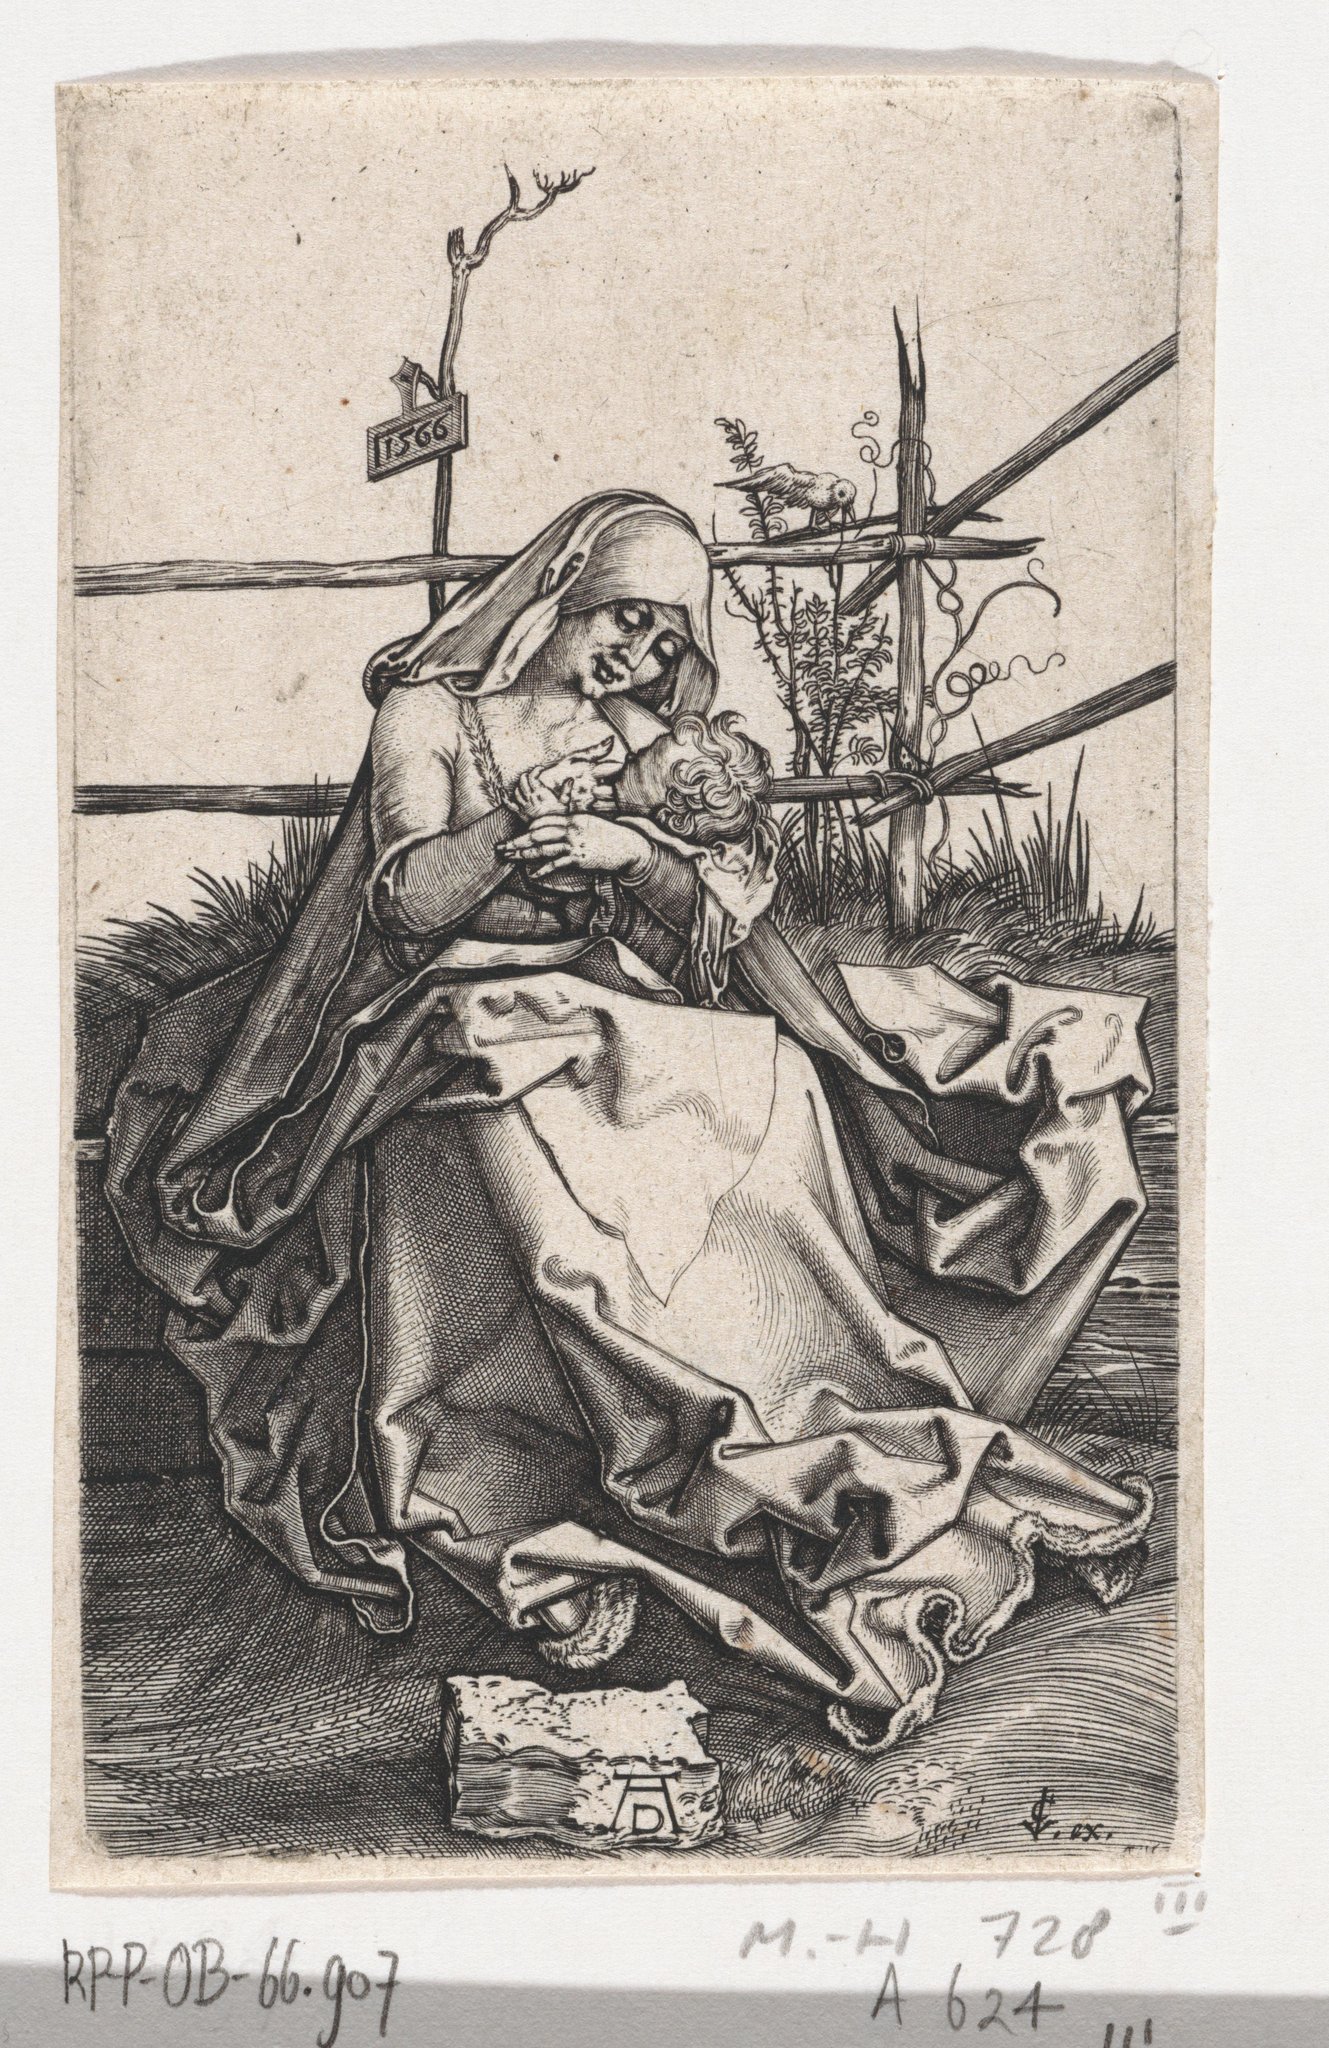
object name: print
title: Maria zoogt het Christuskind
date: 1566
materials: paper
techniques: engraving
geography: antwerp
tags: birds, christ-child suckling, or beginning to suckle, e.g. mary uncovering her breast ~ madonna-representations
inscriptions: collector's mark: Lugt 240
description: Maria zit op het gras en zoogt het Christuskind. Op het hek op de achtergrond zit een vogel. Aan haar voeten ligt een steen met het monogram van Albrecht Dürer.